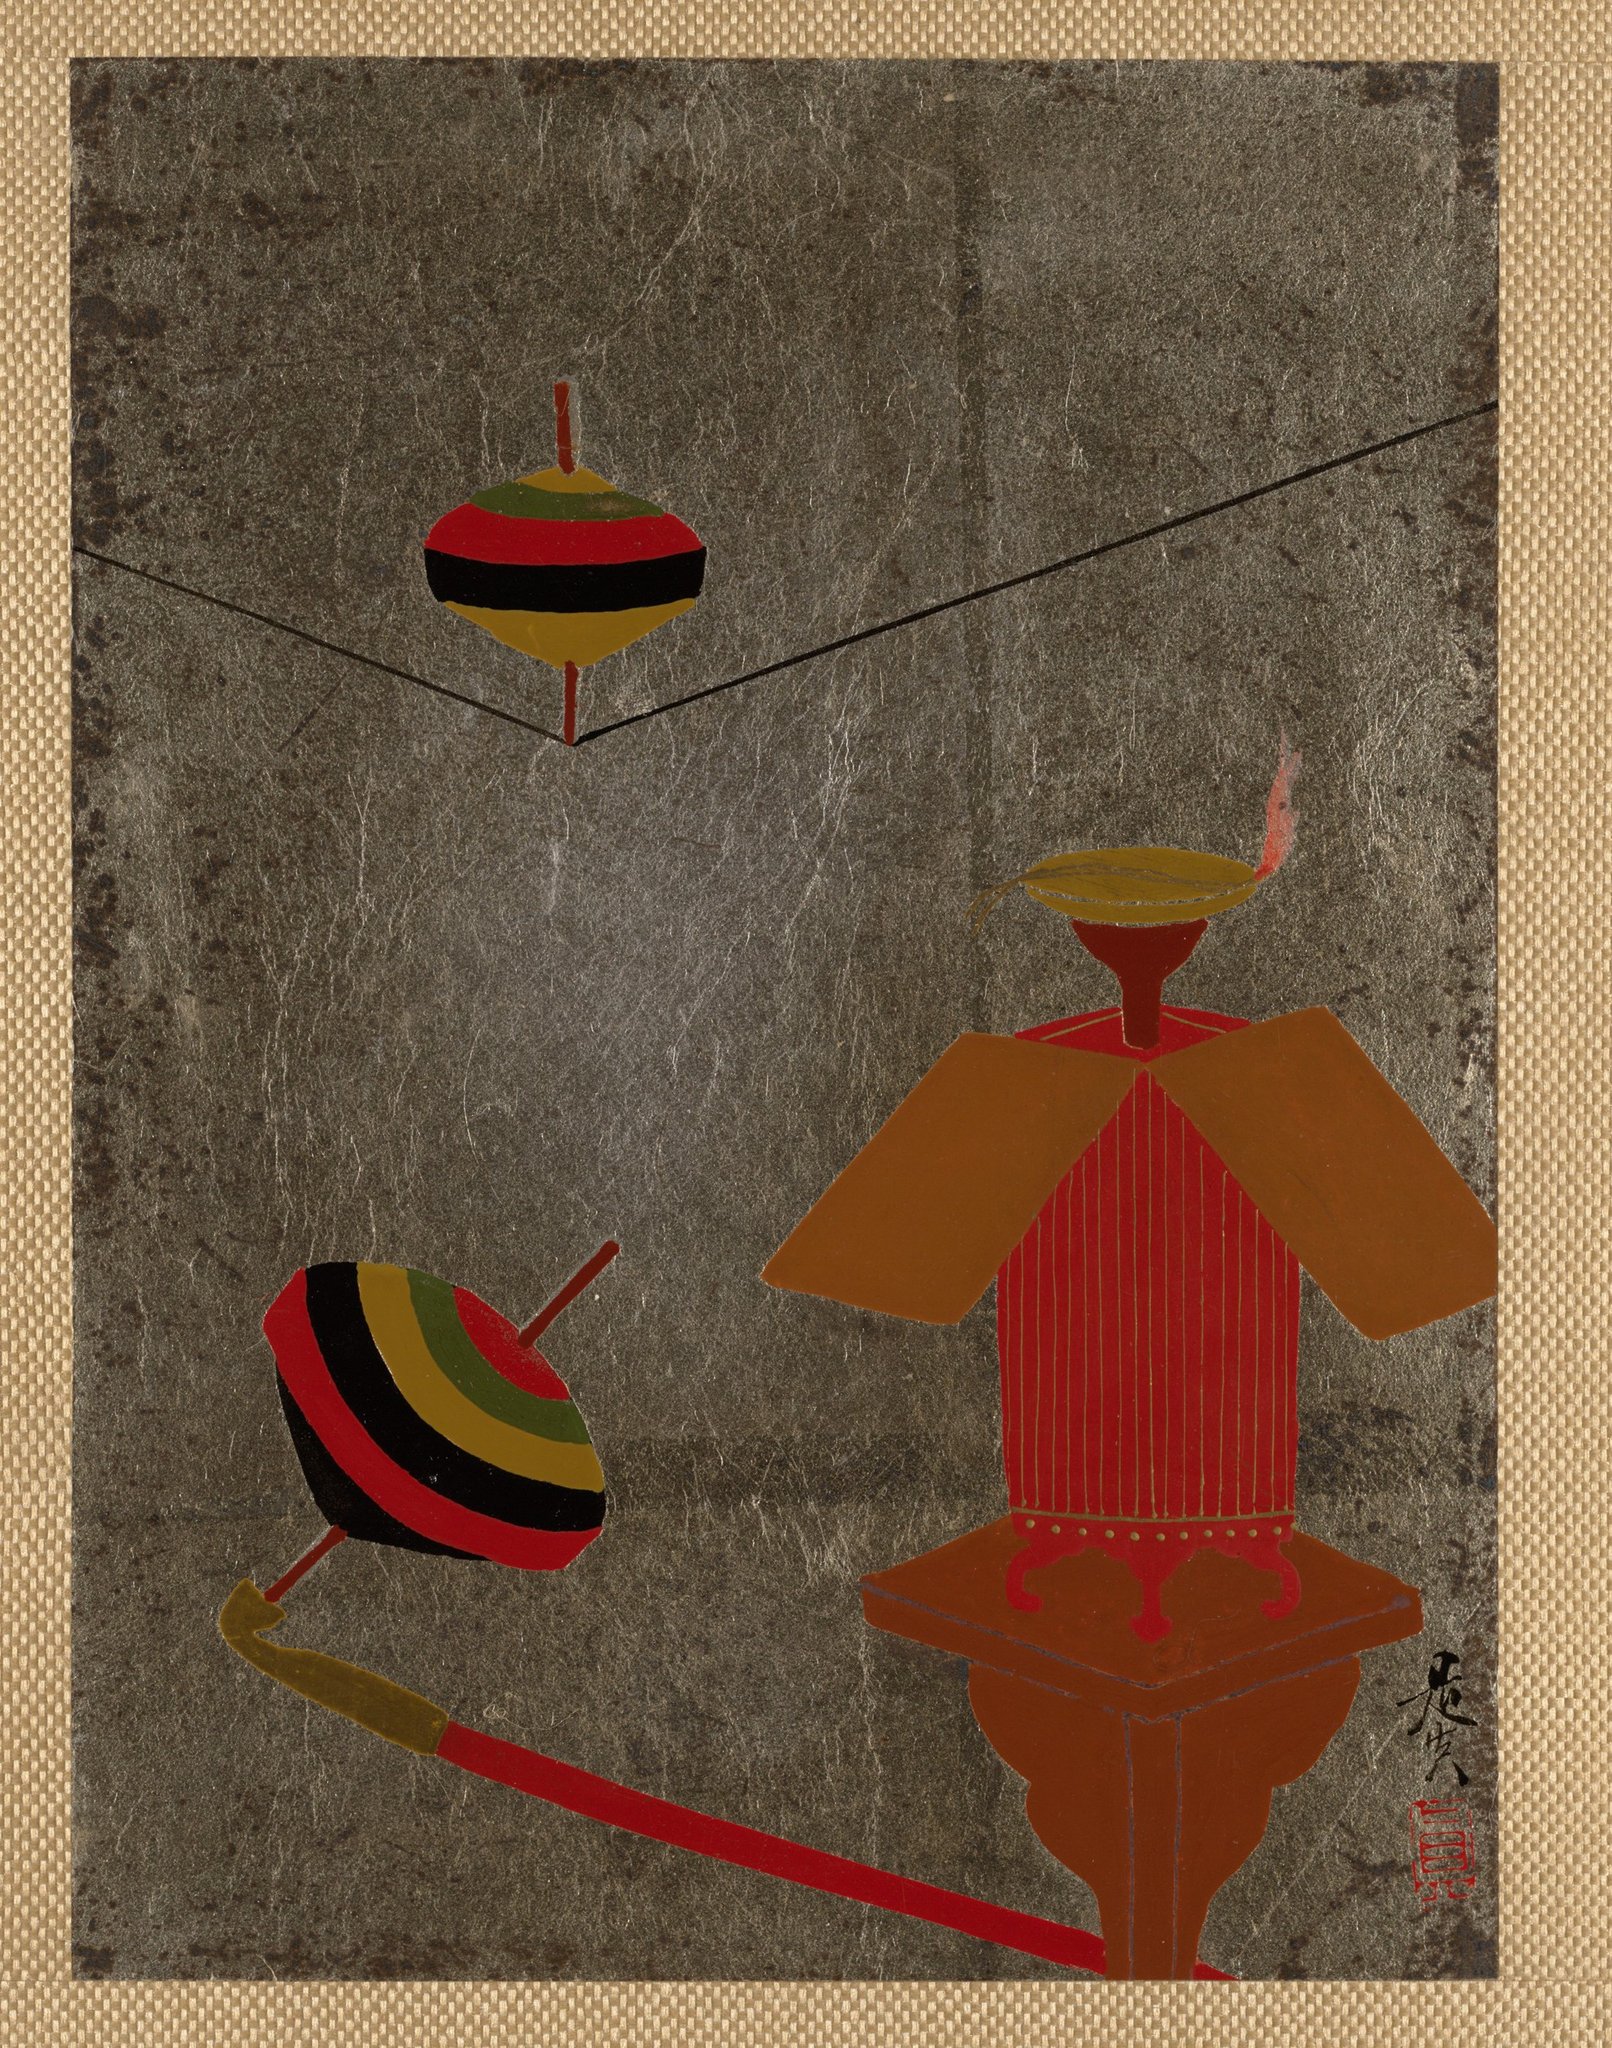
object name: album leaf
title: Tops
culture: japanese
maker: shibata zeshin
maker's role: artist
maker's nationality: japanese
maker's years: 1807-1891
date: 1807-1868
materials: lacquer, paper, silver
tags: toys